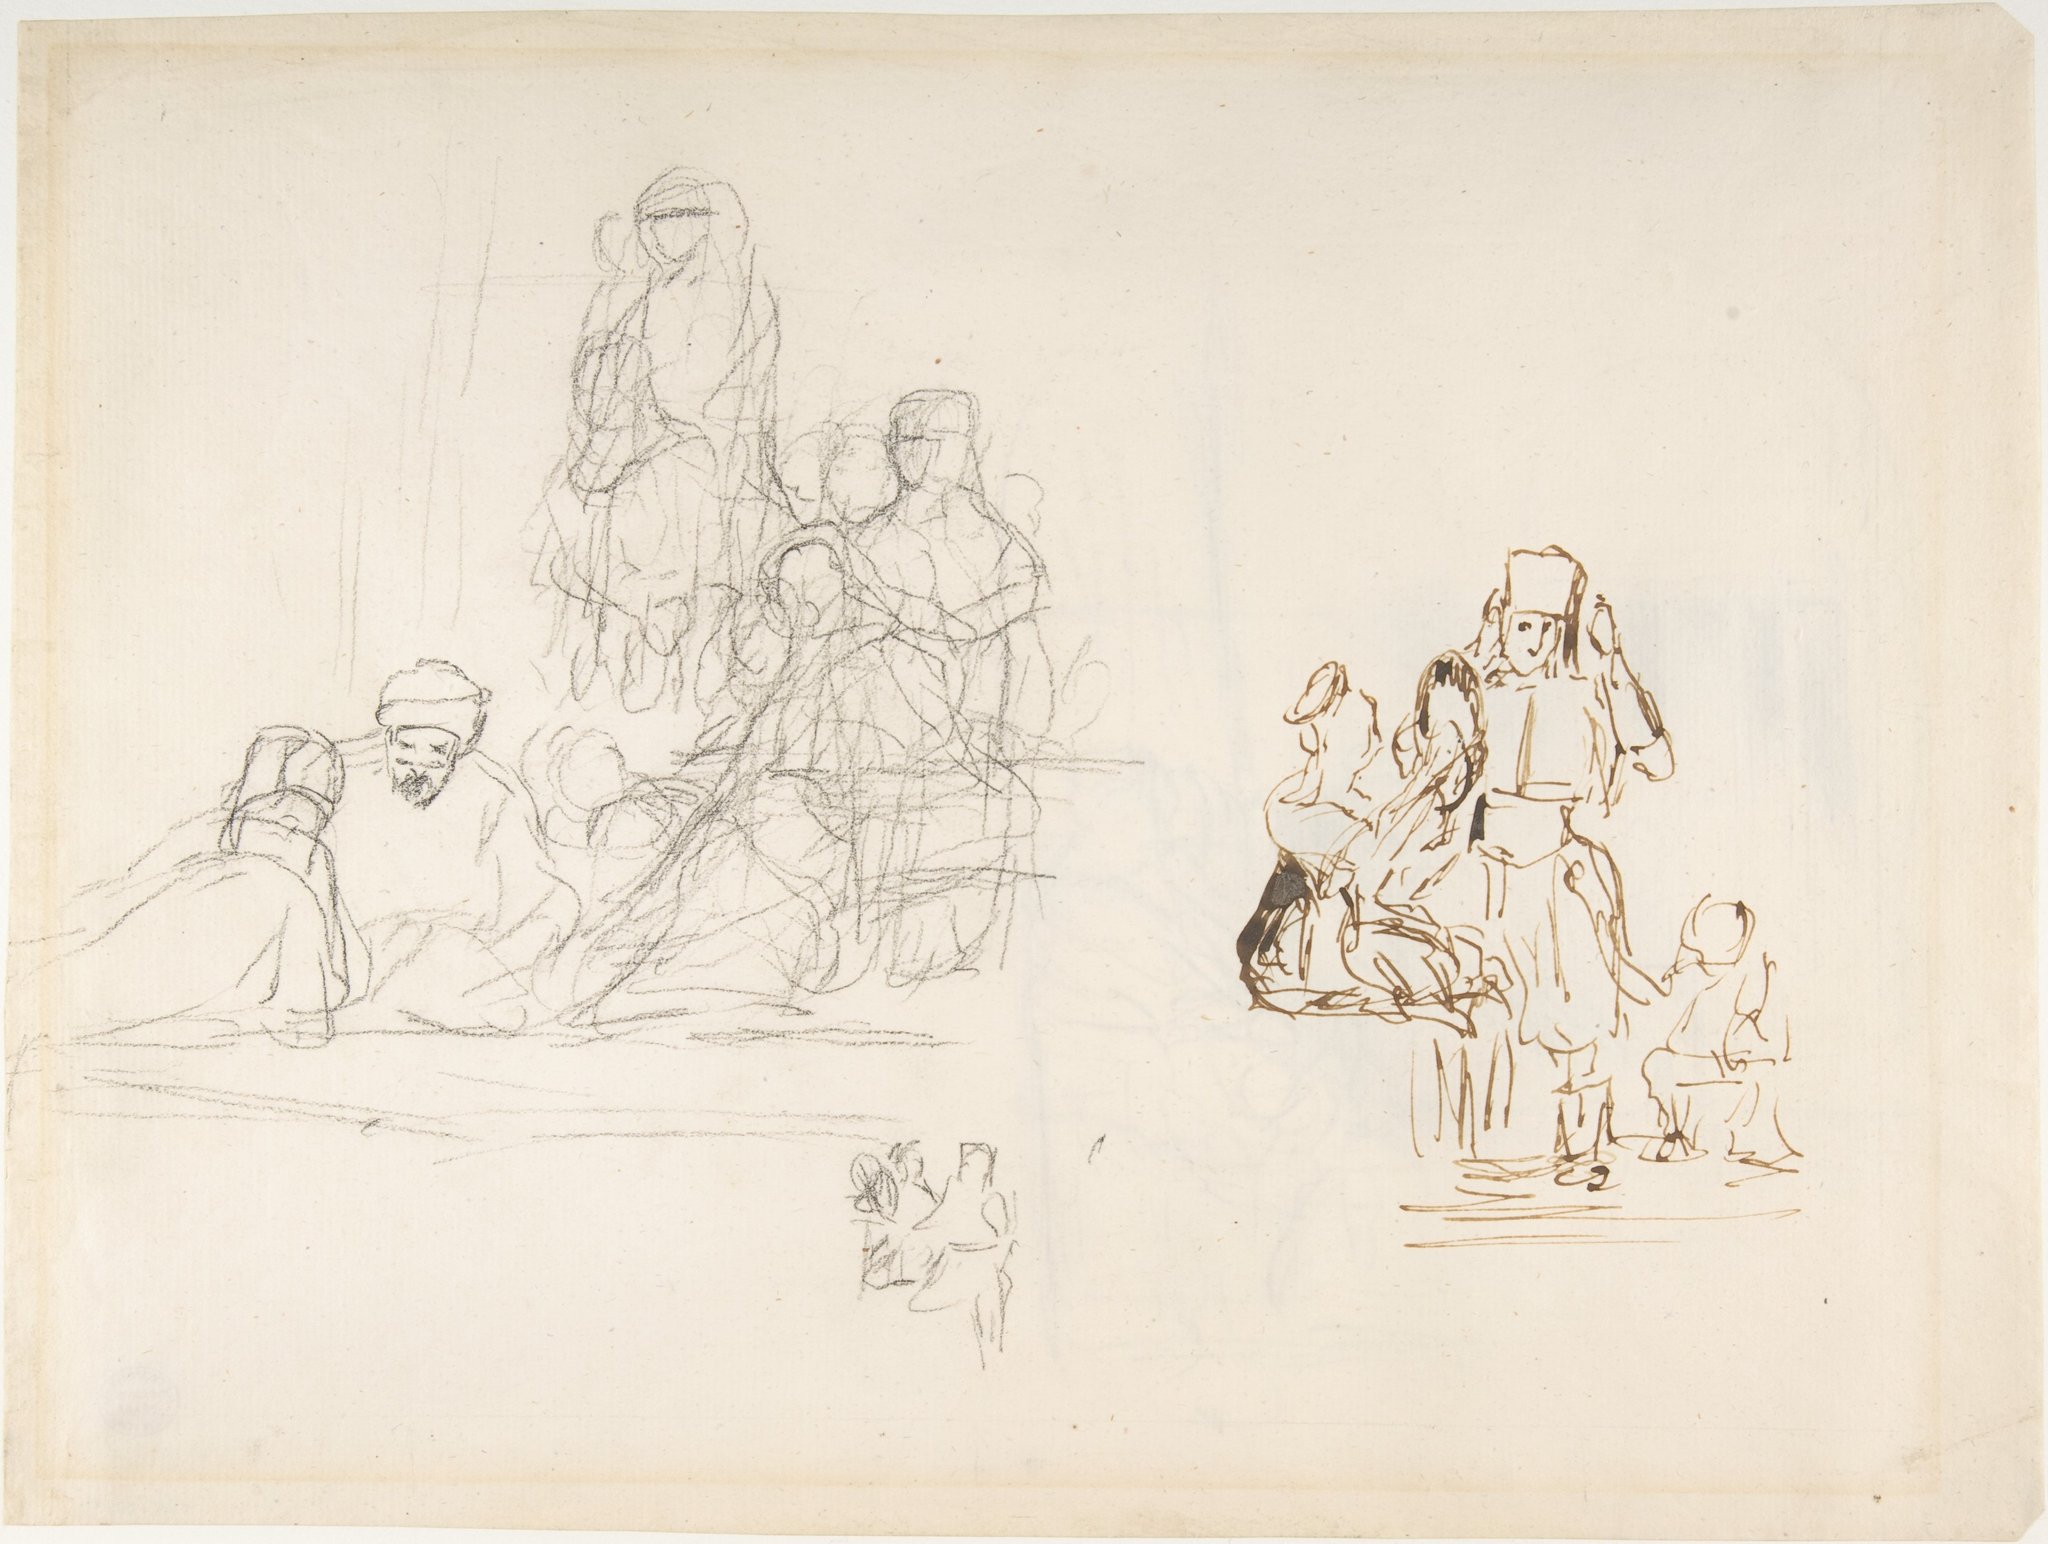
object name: drawing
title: Studies of two groups of Turkish figures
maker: sir david wilkie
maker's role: artist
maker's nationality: british, scottish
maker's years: 1785-1841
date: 1841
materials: chalk, ink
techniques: pen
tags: men,women